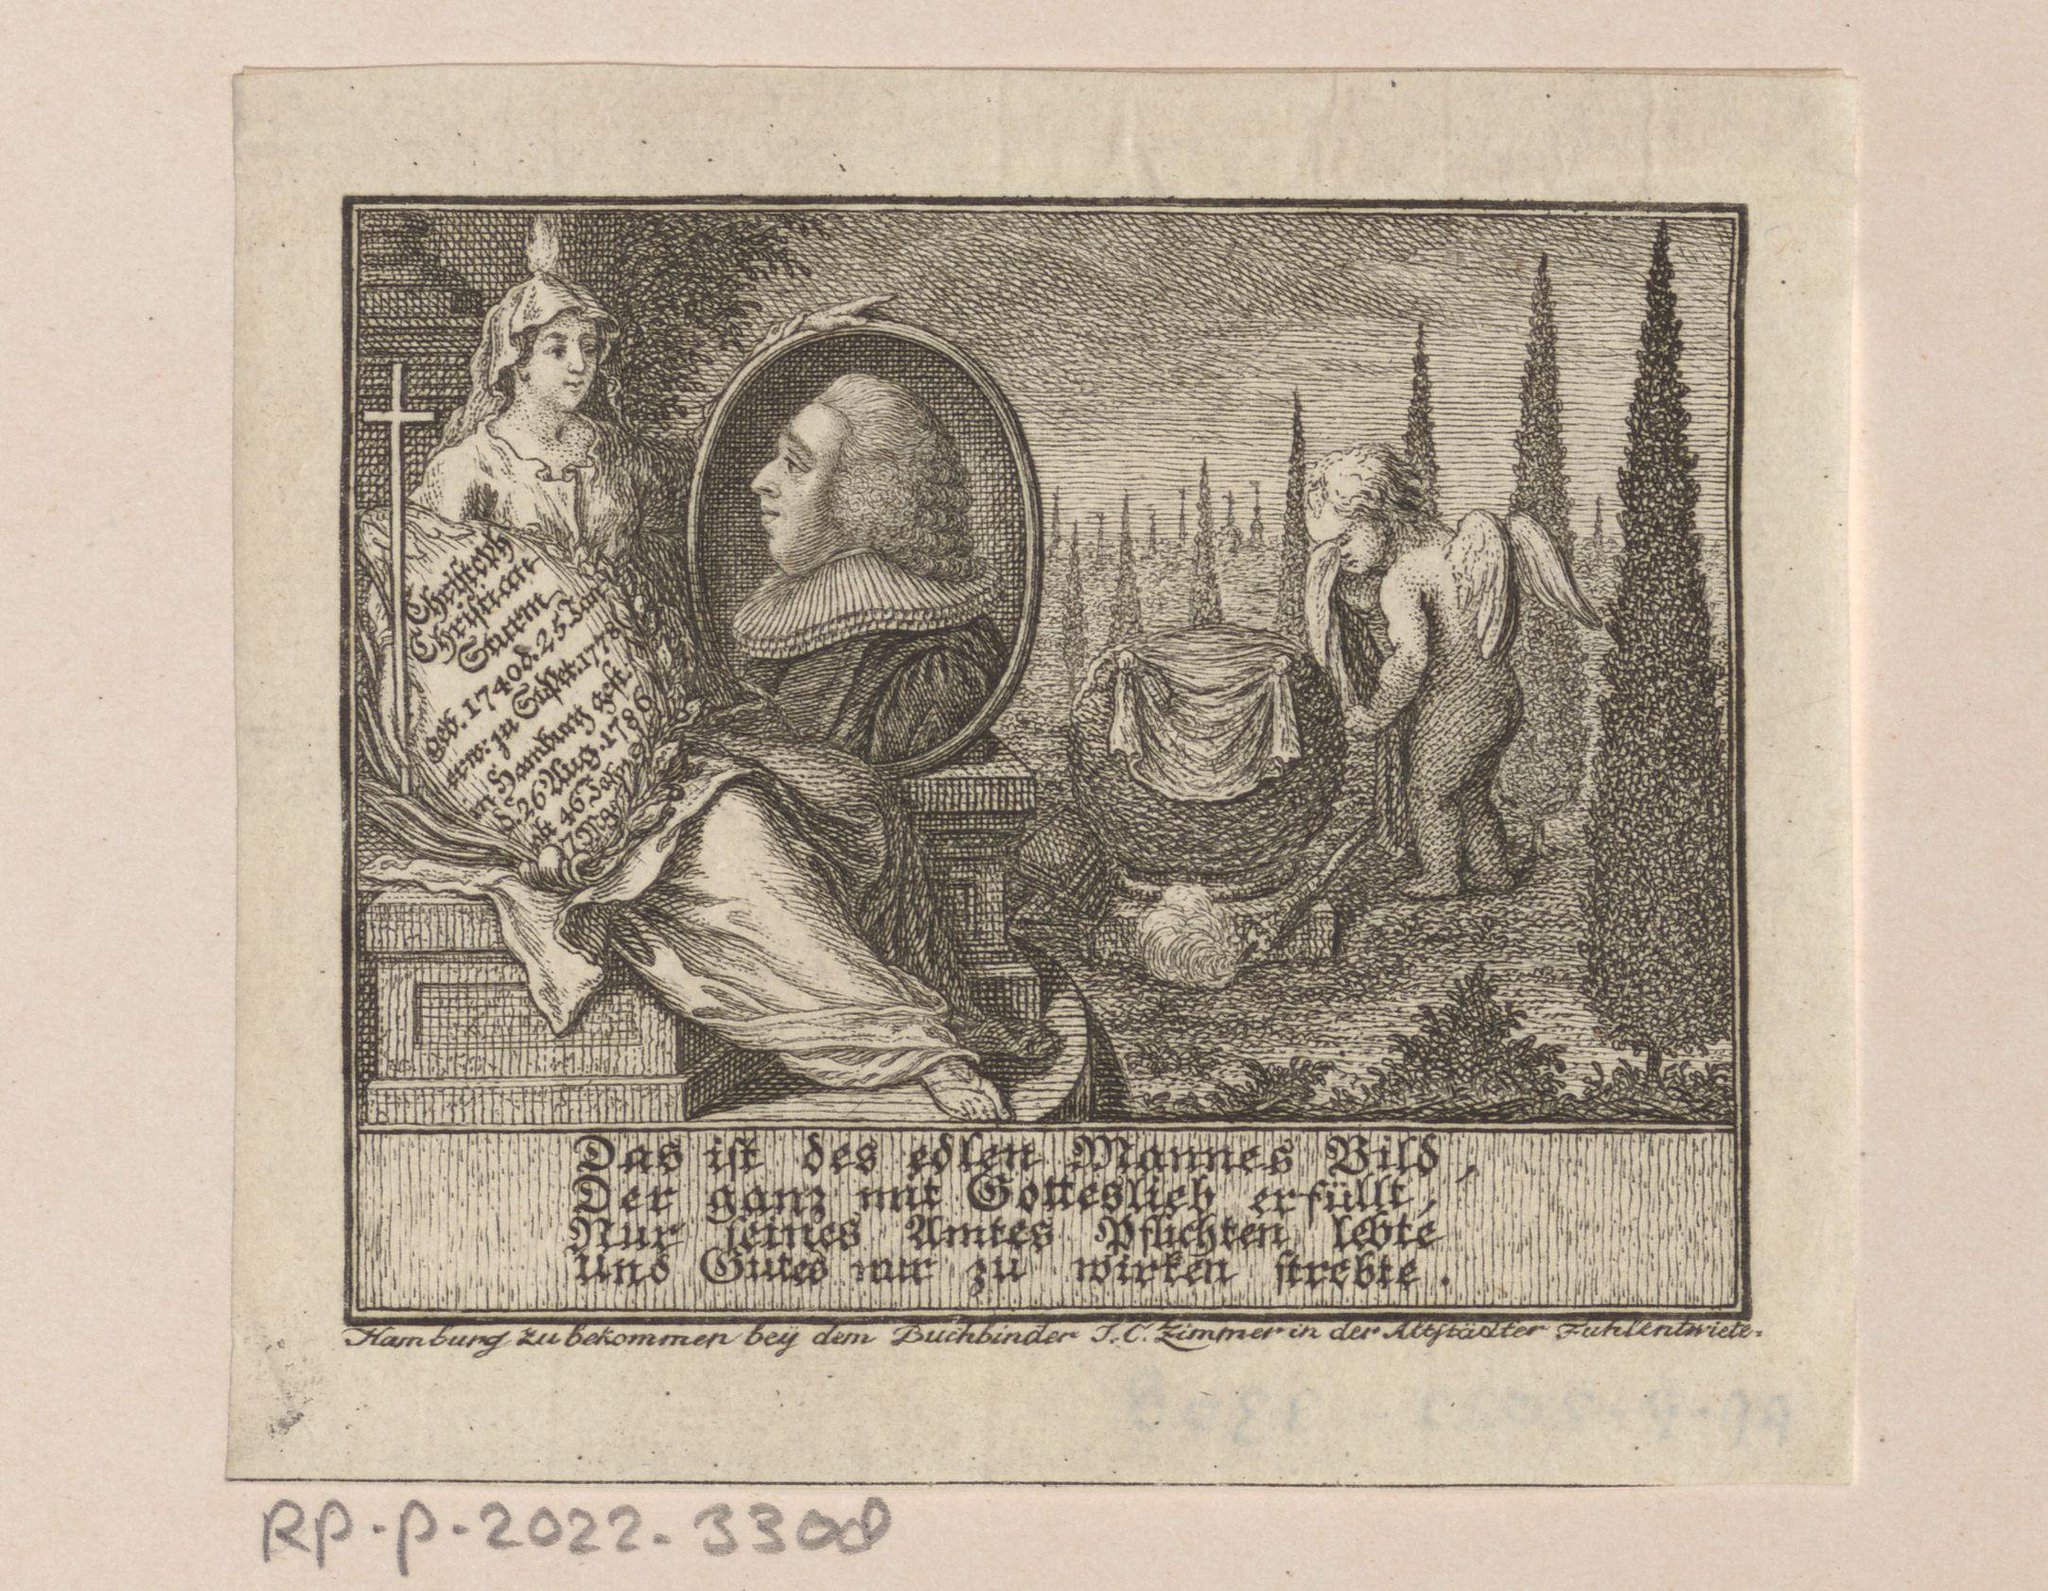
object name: print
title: Geloof (Fides) met een portret in medaillon van Christoph Christian Sturm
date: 1786-1790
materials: paper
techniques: etching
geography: hamburg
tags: augsburg, fides (faith) as roman personification, torch, theologian, ornament ~ medallion, historical persons, cupids: 'amores', 'amoretti', 'putti'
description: Met een vierregelig onderschrift in het Duits.